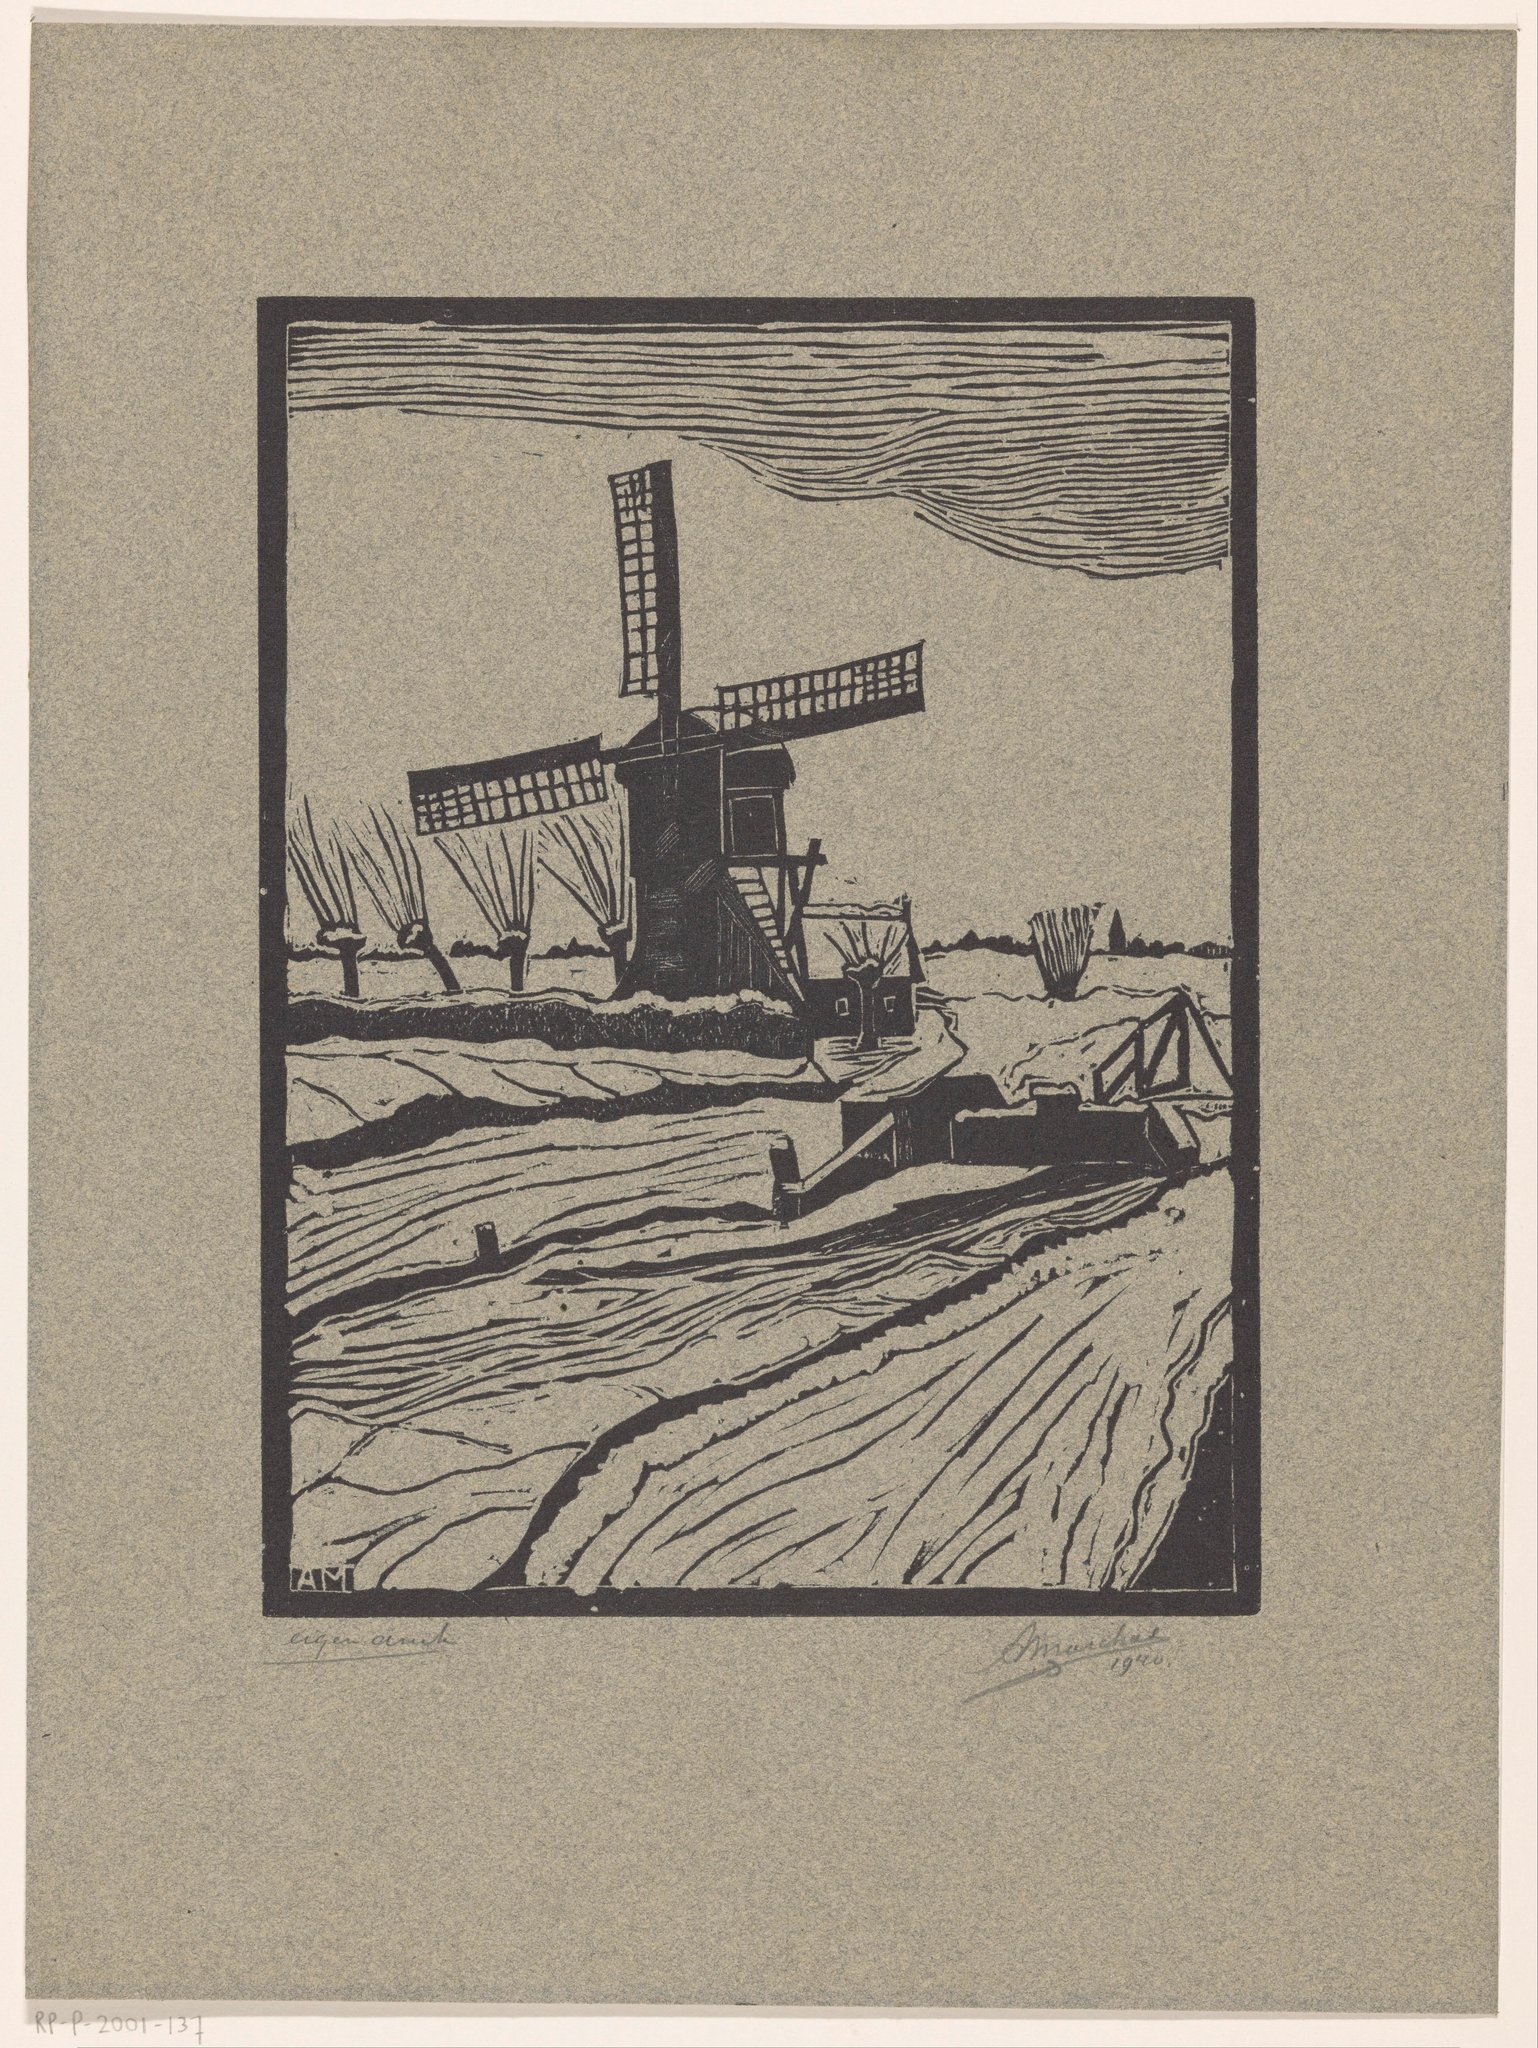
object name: print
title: Winterlandschap met molen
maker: a. marschal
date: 1940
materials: paper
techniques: woodcut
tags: windmill in landscape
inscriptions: signature and date: ‘A. Marchal 1940’, annotation: ‘eigen druk’, monogram: ‘AM’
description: Winters polderlandschap met een molen en drie knotwilgen.